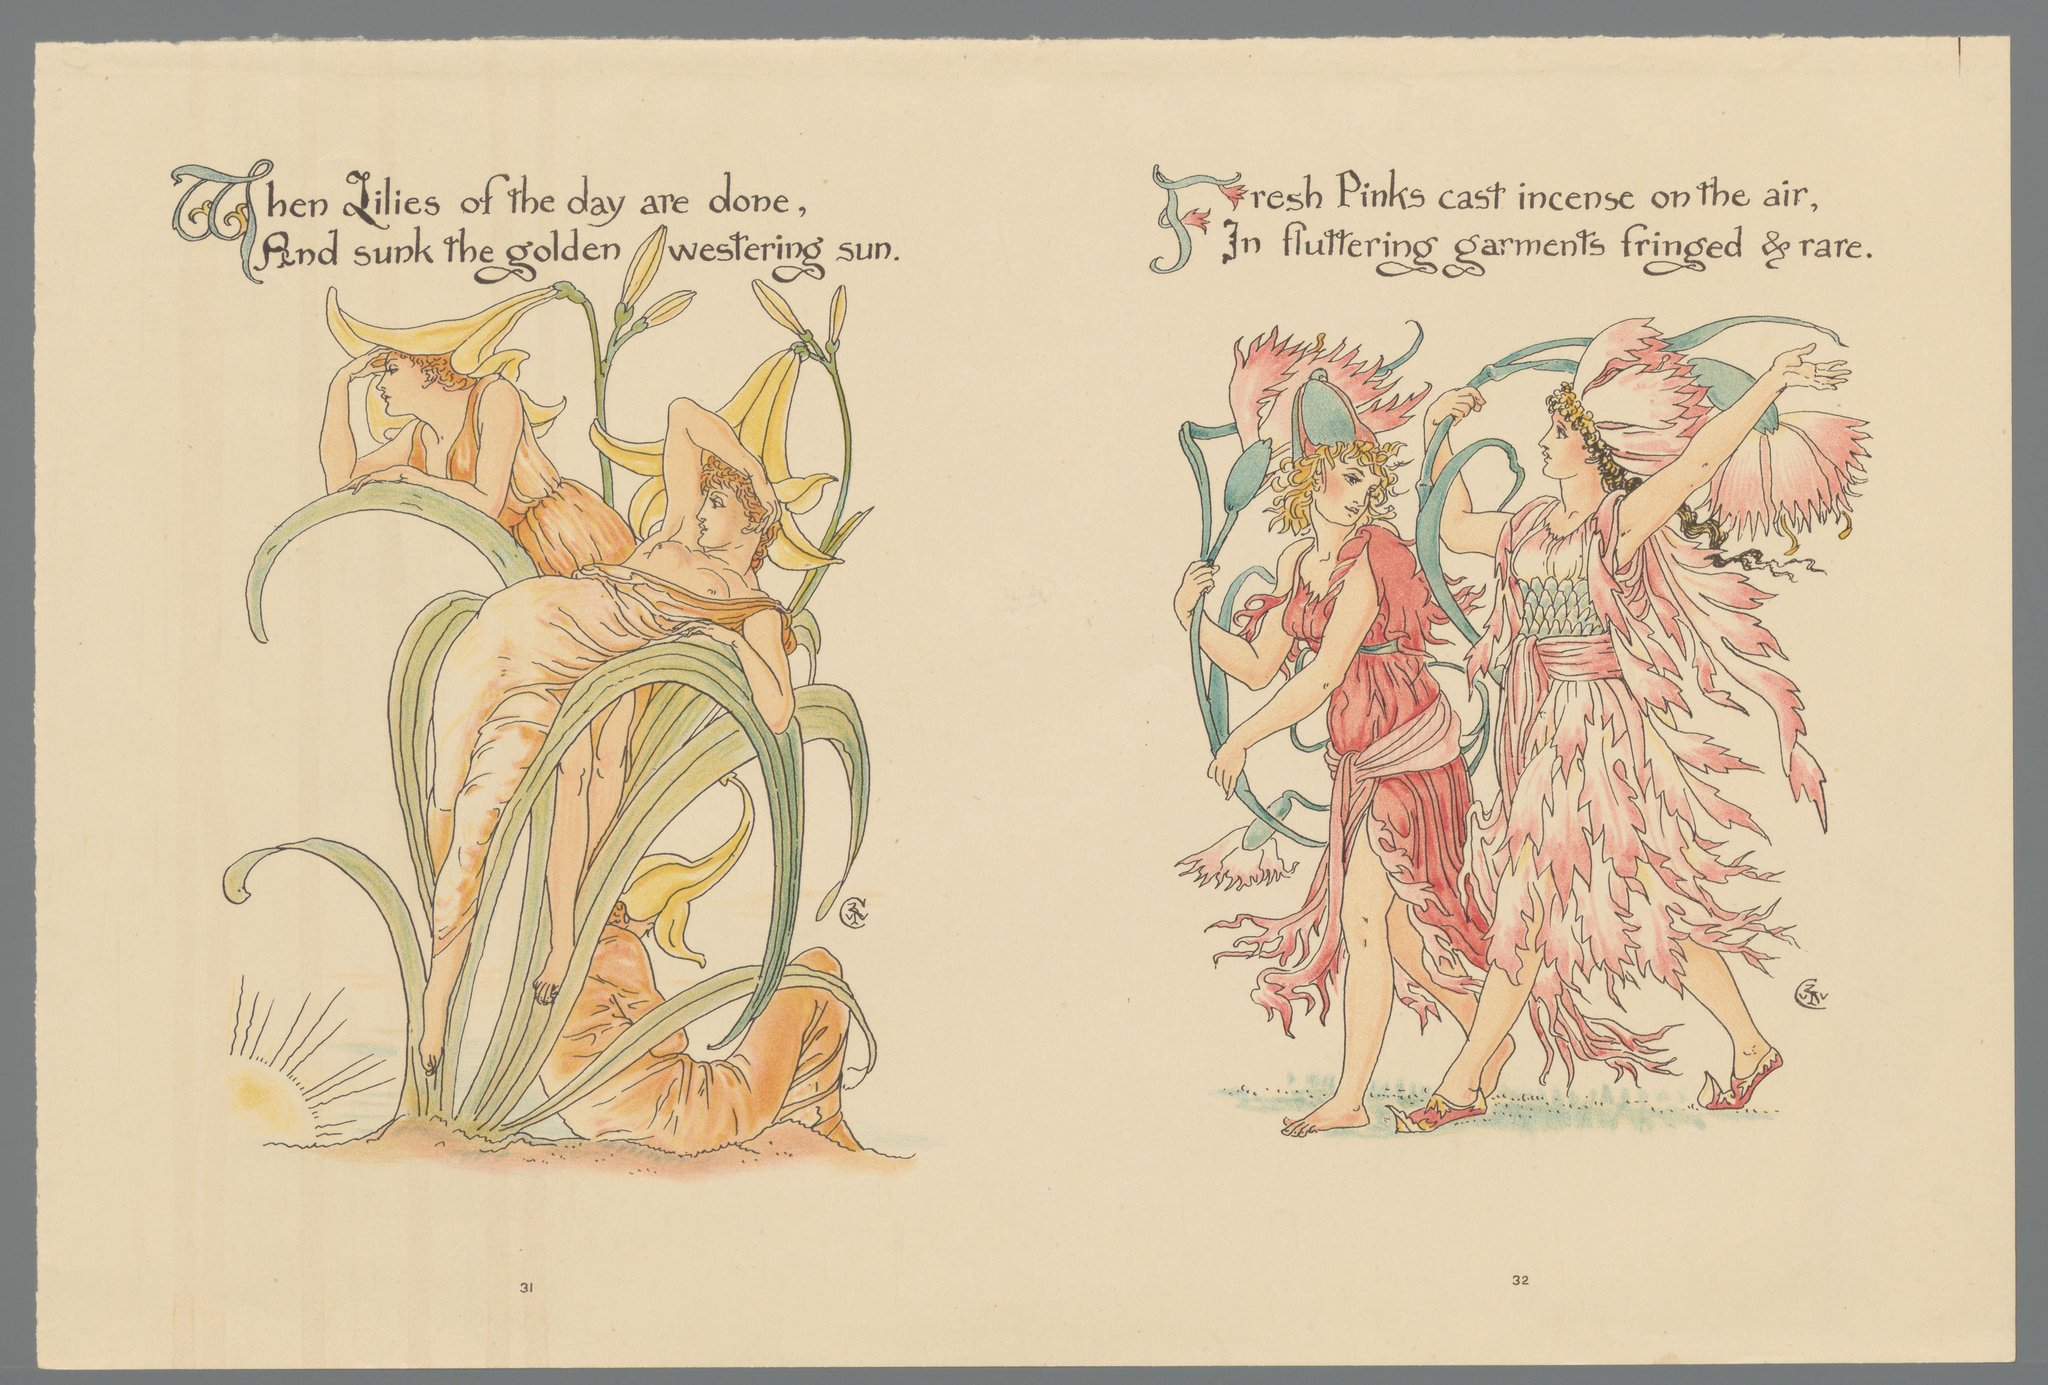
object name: print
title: Vijf figuren in bloemenkostuum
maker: walter crane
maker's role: draughtsman, print maker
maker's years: 1845-1915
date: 1889-1927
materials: paper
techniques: lithograph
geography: london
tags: flowers, plants behaving as human beings or animals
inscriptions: collector's mark: Lugt 2228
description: Prent uit: Crane, Walter. Flora's Feast, a masque of flowers. Londen: Cassel & Co., 1889. Of een latere uitgave.